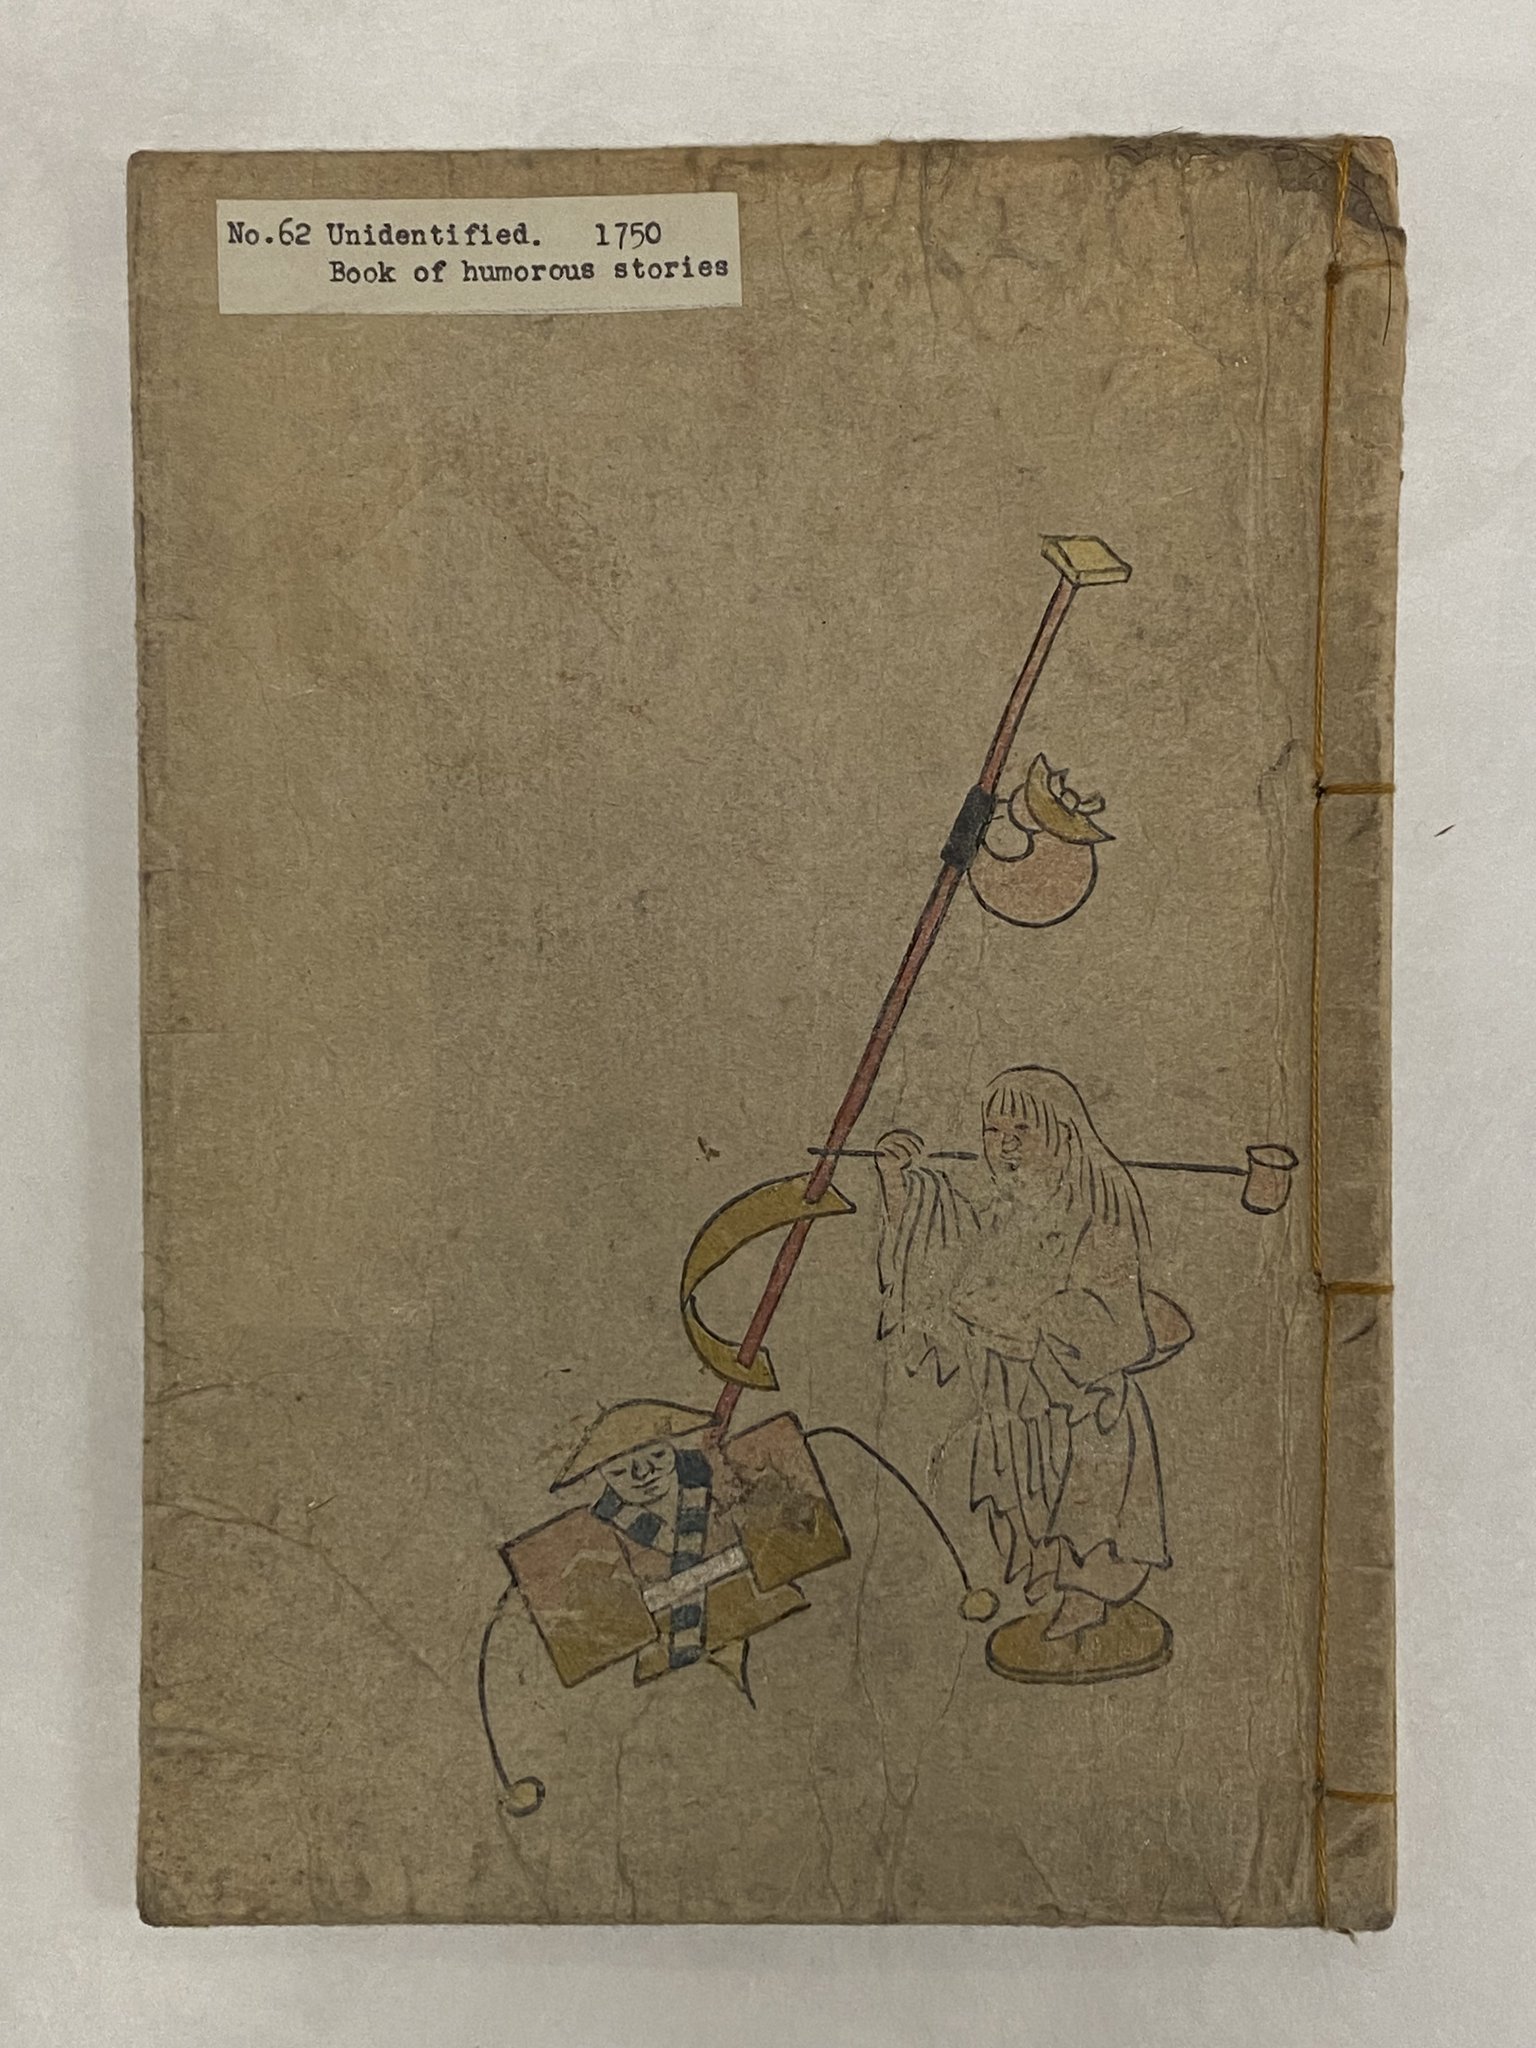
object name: illustrated book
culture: japanese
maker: unidentified artist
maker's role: artist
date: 1750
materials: ink, paper